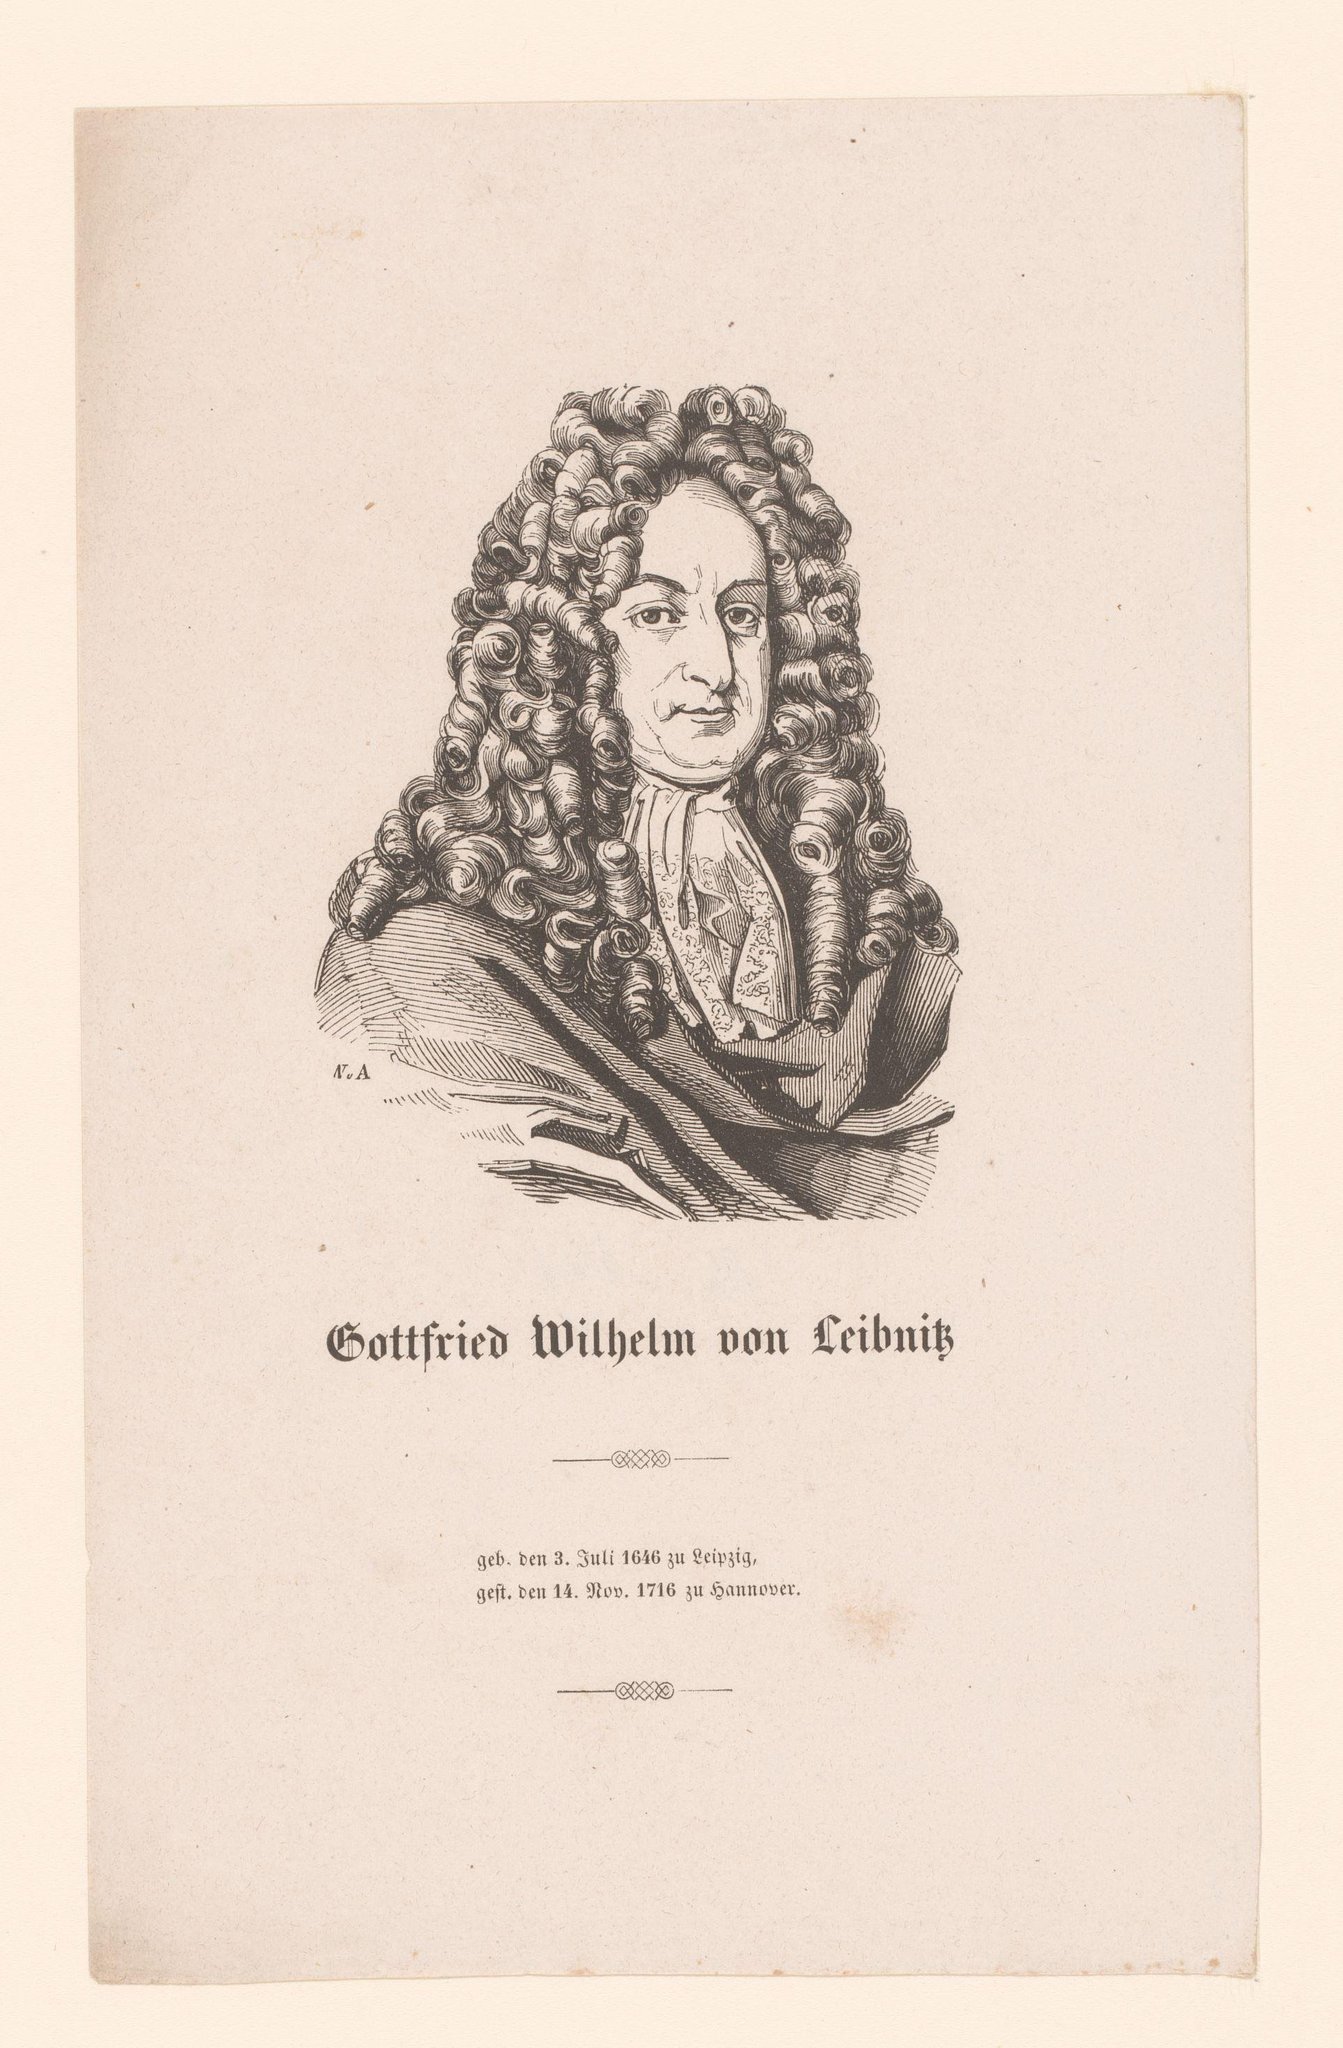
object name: print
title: Portret van Gottfried Wilhelm von Leibniz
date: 1800-1899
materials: paper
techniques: engraving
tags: historical persons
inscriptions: collector's mark: Lugt 2228